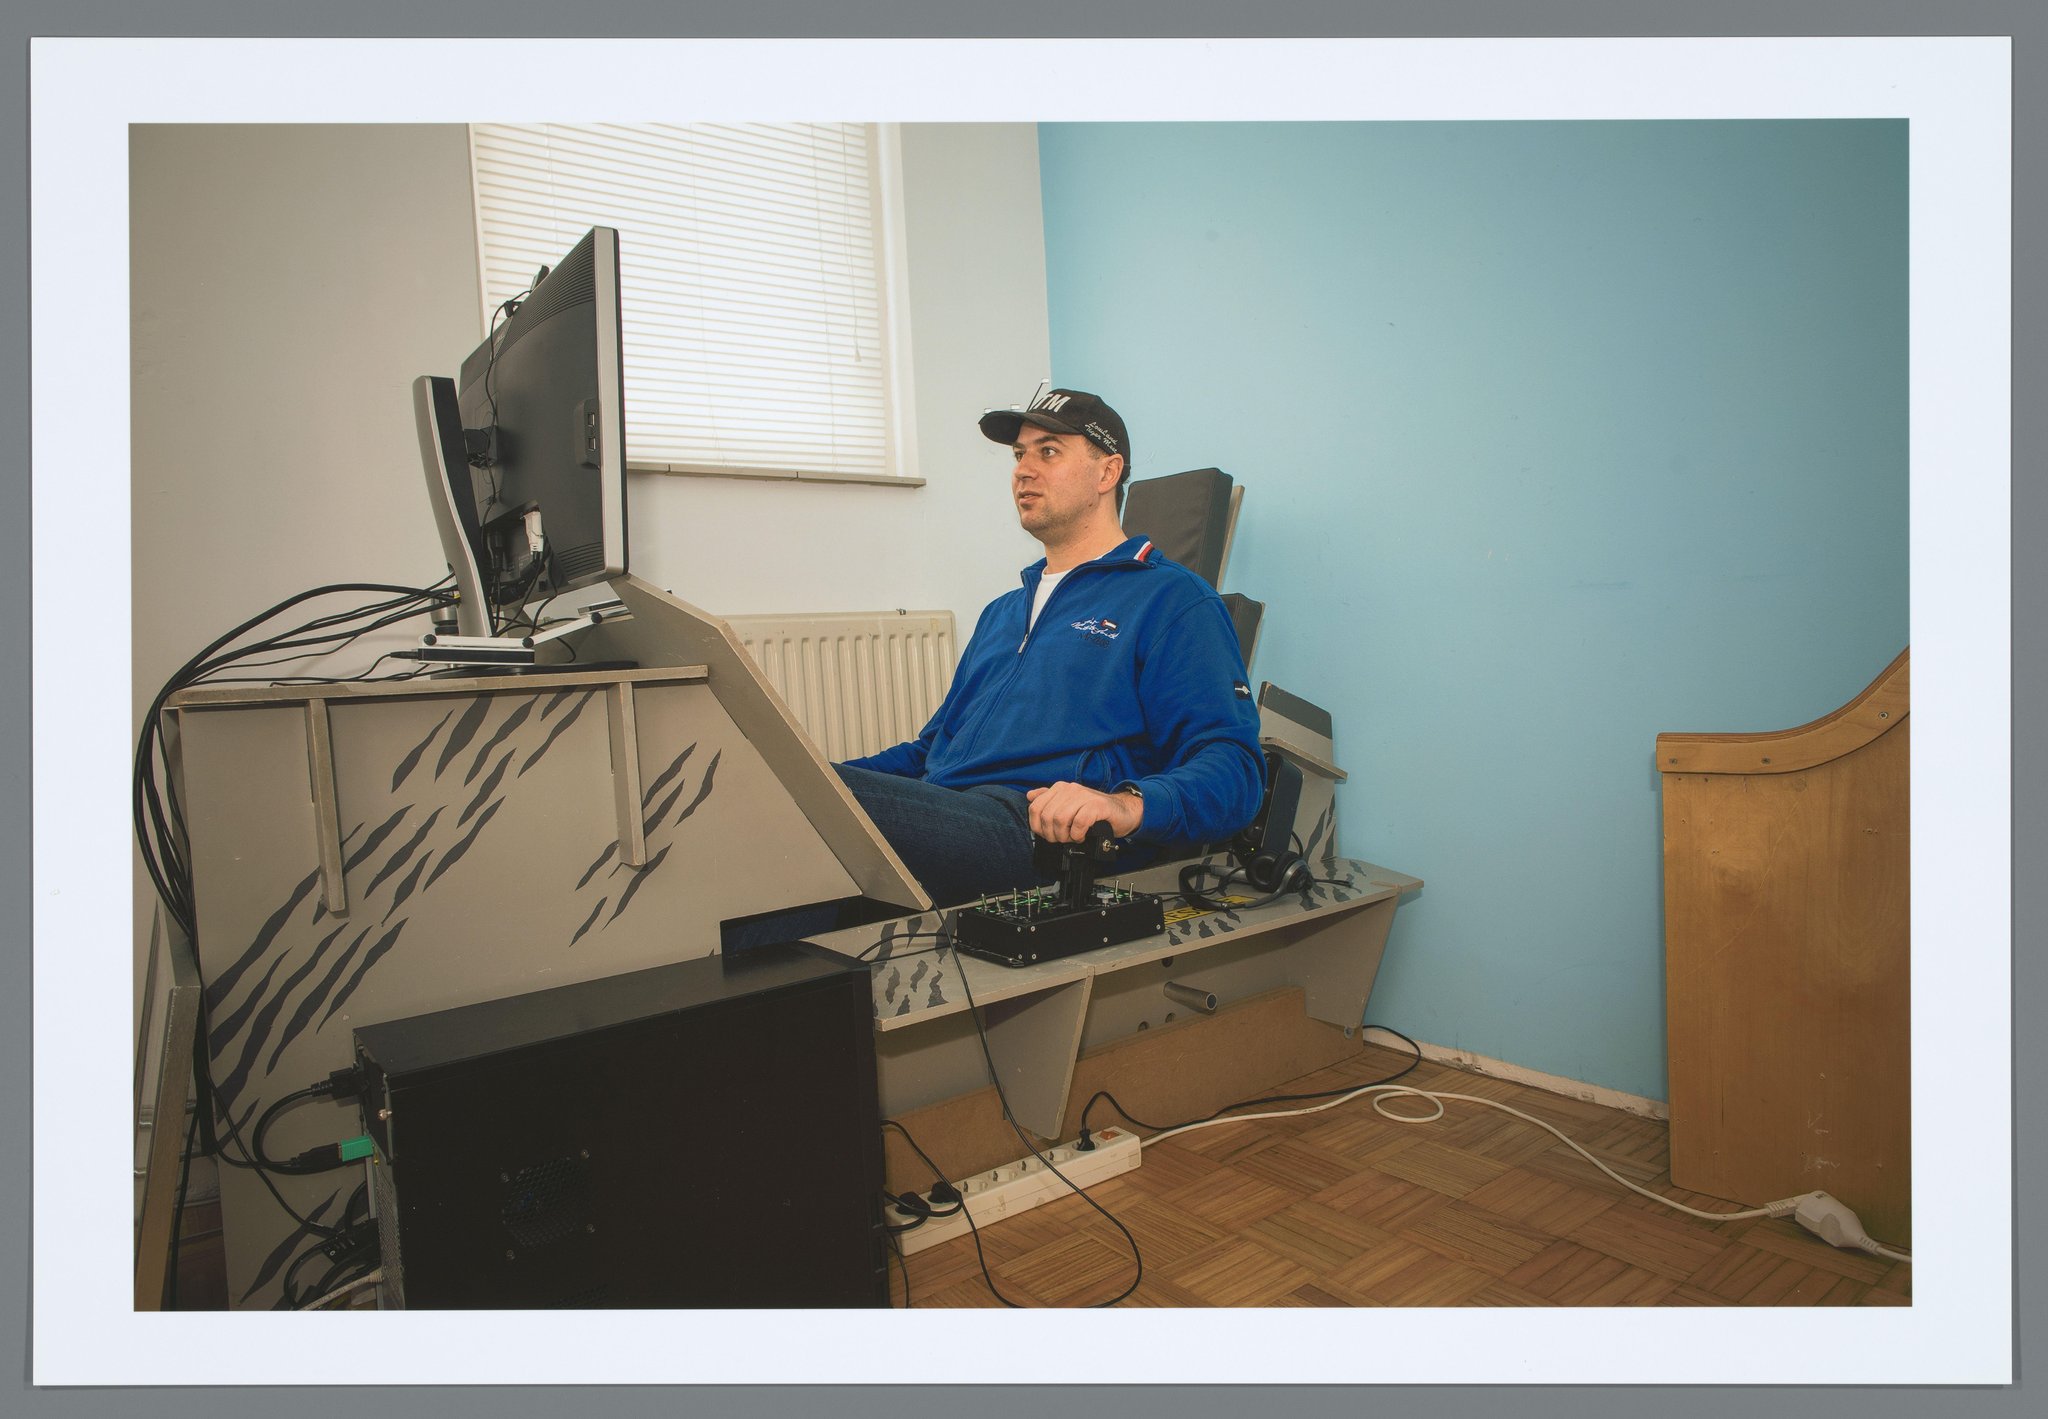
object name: photograph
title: Ground Control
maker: gerrit meerman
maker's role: fotograaf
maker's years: 1957-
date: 2015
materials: ink, paper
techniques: inkjet print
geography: netherlands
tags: airborne traffic, aviation, computer, equation-solving machine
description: "Joe Kurr, teamcaptain". Vanaf zijn vroege jeugd is Bas geboeid door de luchtvaart. Hij vloog toen op de computer van zijn vader met een F-16 en F-18, maar was daar snel op uitgekeken: alles zag er zo knullig uit. Op zijn vijftiende begon hij met het spotten van vliegtuigen op vliegbasis Gilze-Rijen. In 1997 ontstond bij hem de interesse in het virtueel vliegen van een militair toestel, de SU-27 Flanker. Samen met vrienden vormde hij het Dutch Flanker Display Team. De dinsdagavond is de vaste avond waarop de vijf leden van het team online vliegen. Zij schrijven gezamenlijk de missies die gevlogen worden. De wens van Bas is om een statische stoel te bouwen waarin g-krachten gesimuleerd kunnen worden door het aanspannen van riemen.